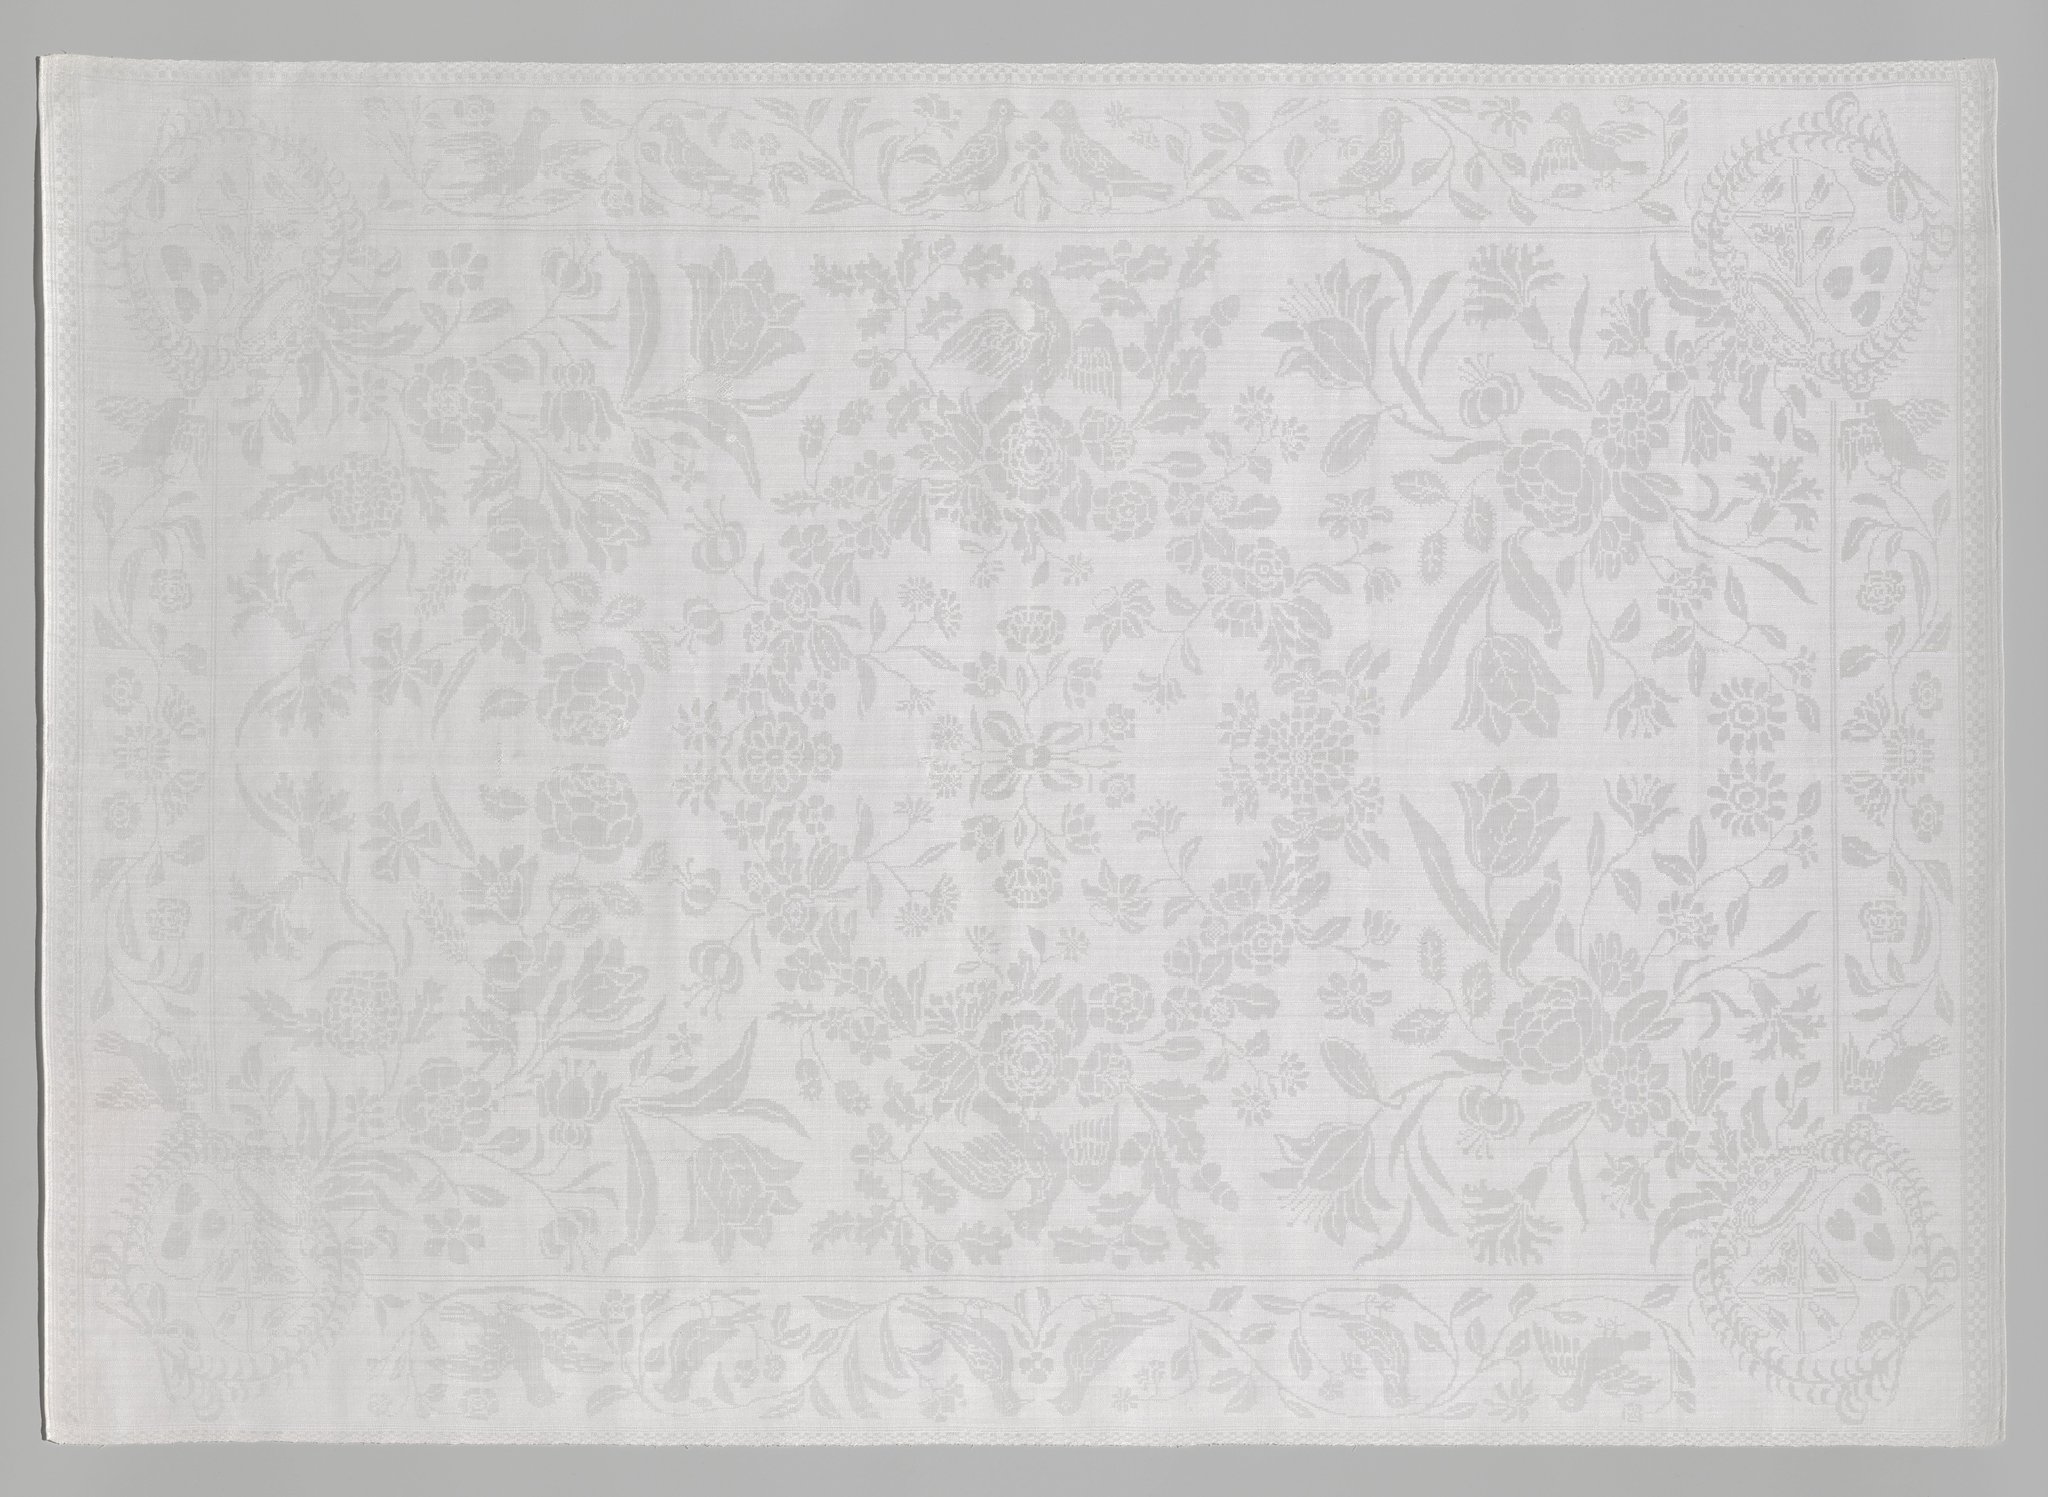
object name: napkin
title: Servet met bloemenpatroon en wapens van "Ten Hove en Van Bebber"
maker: Anonymous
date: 1672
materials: linen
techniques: damask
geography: northern netherlands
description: Wit linnen damasten servet met symmetrisch gespiegeld bloempatroon en in de vier hoeken wapens van "Ten Hove en Van Bebber". Satijn 5 binding